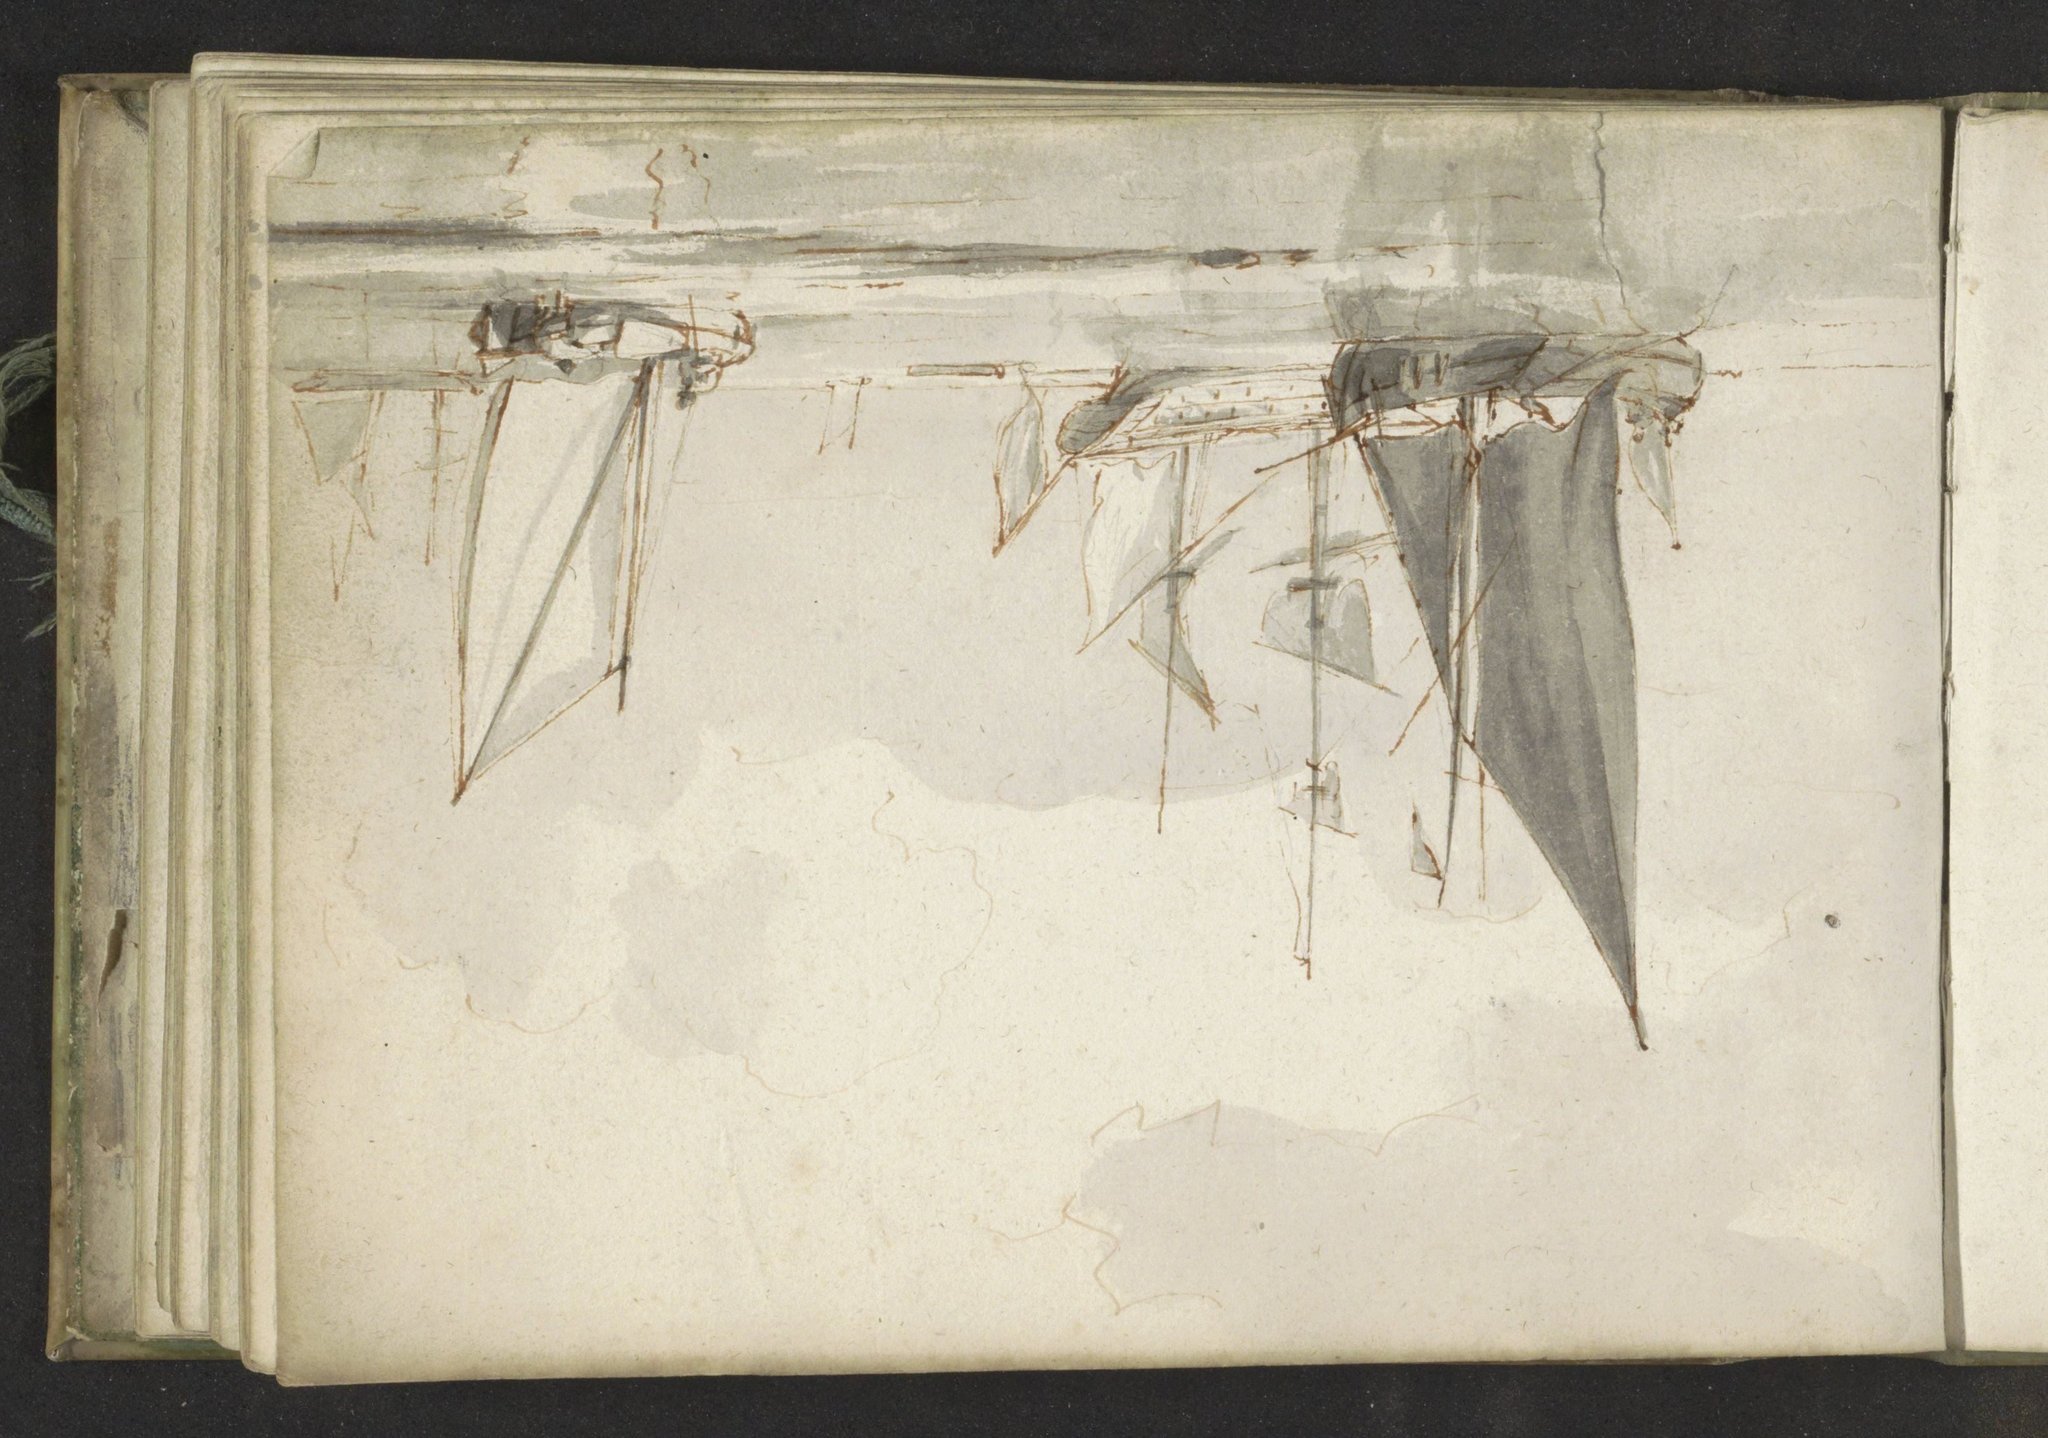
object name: sketchbook leaf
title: Zeilschepen op kalm water voor een kust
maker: martinus schouman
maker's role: draughtsman, painter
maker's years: 1770-1848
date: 1780-1848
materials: ink, paper, pencil, watercolor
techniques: brush, pen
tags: sailing-ship, sailing-boat, coast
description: Blad 52 verso uit een schetsboek met 53 bladen.